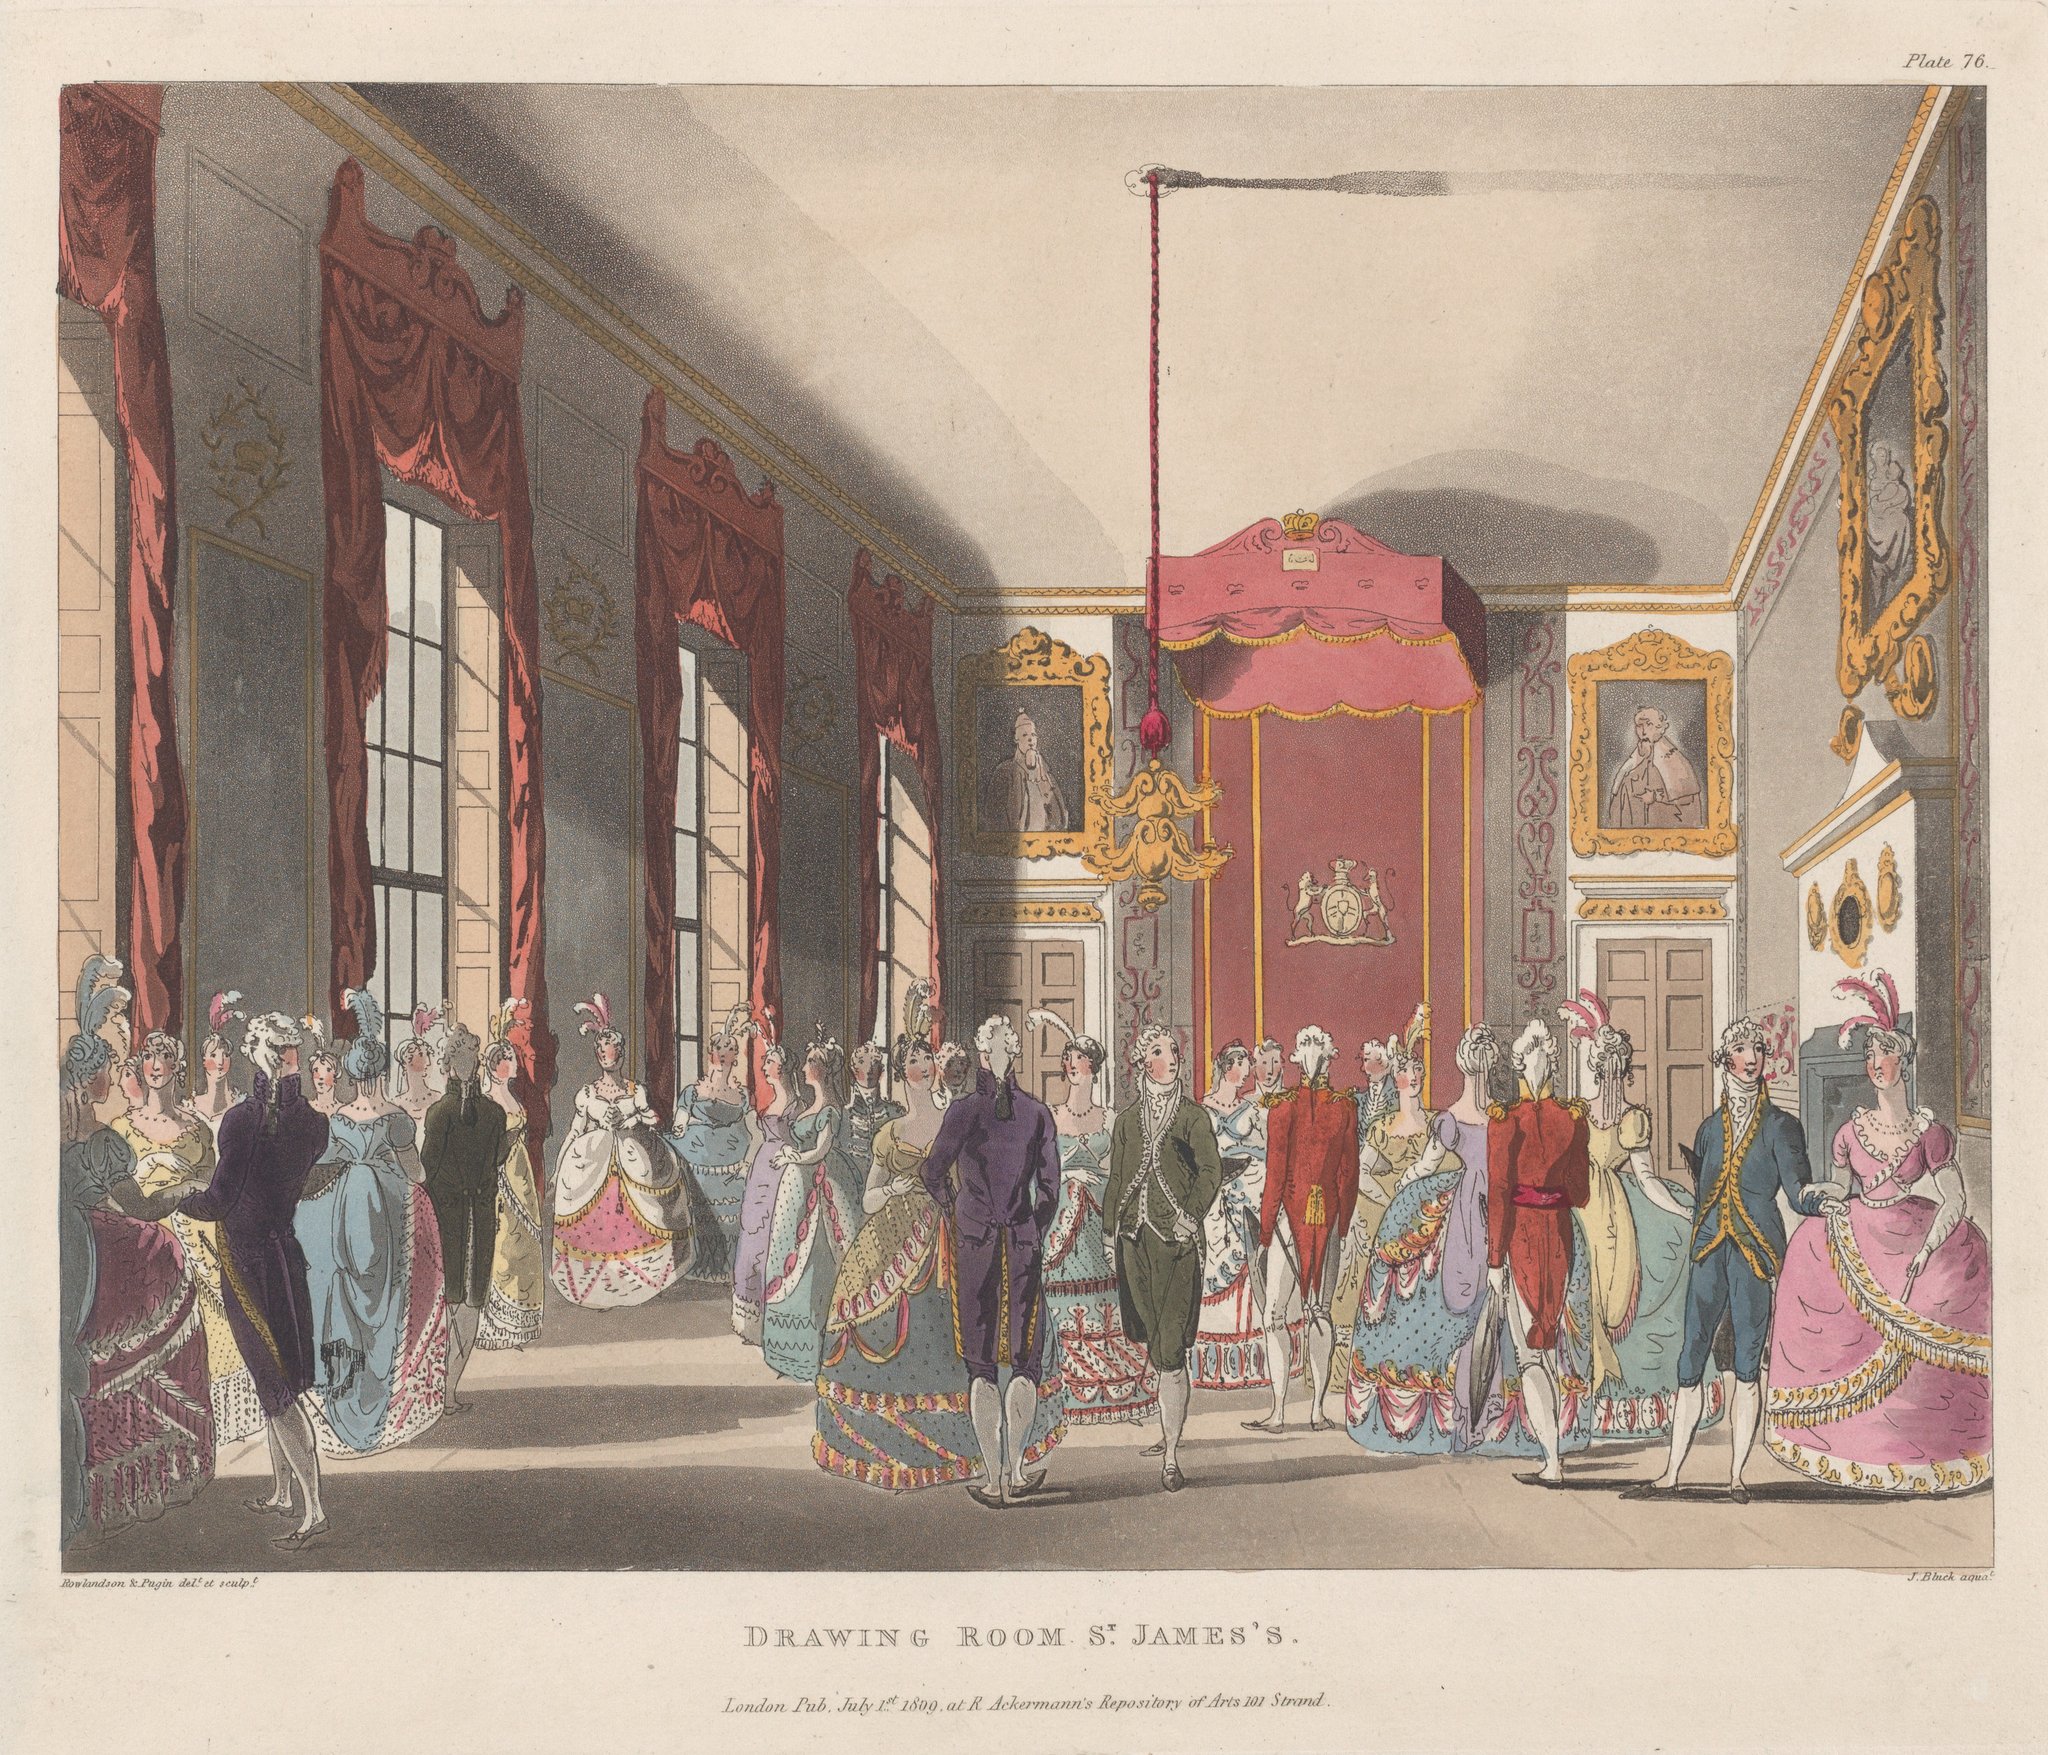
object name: print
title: Drawing Room St James's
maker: thomas rowlandson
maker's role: artist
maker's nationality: british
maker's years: 1757-1827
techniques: aquatint, etching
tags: interiors,men,women